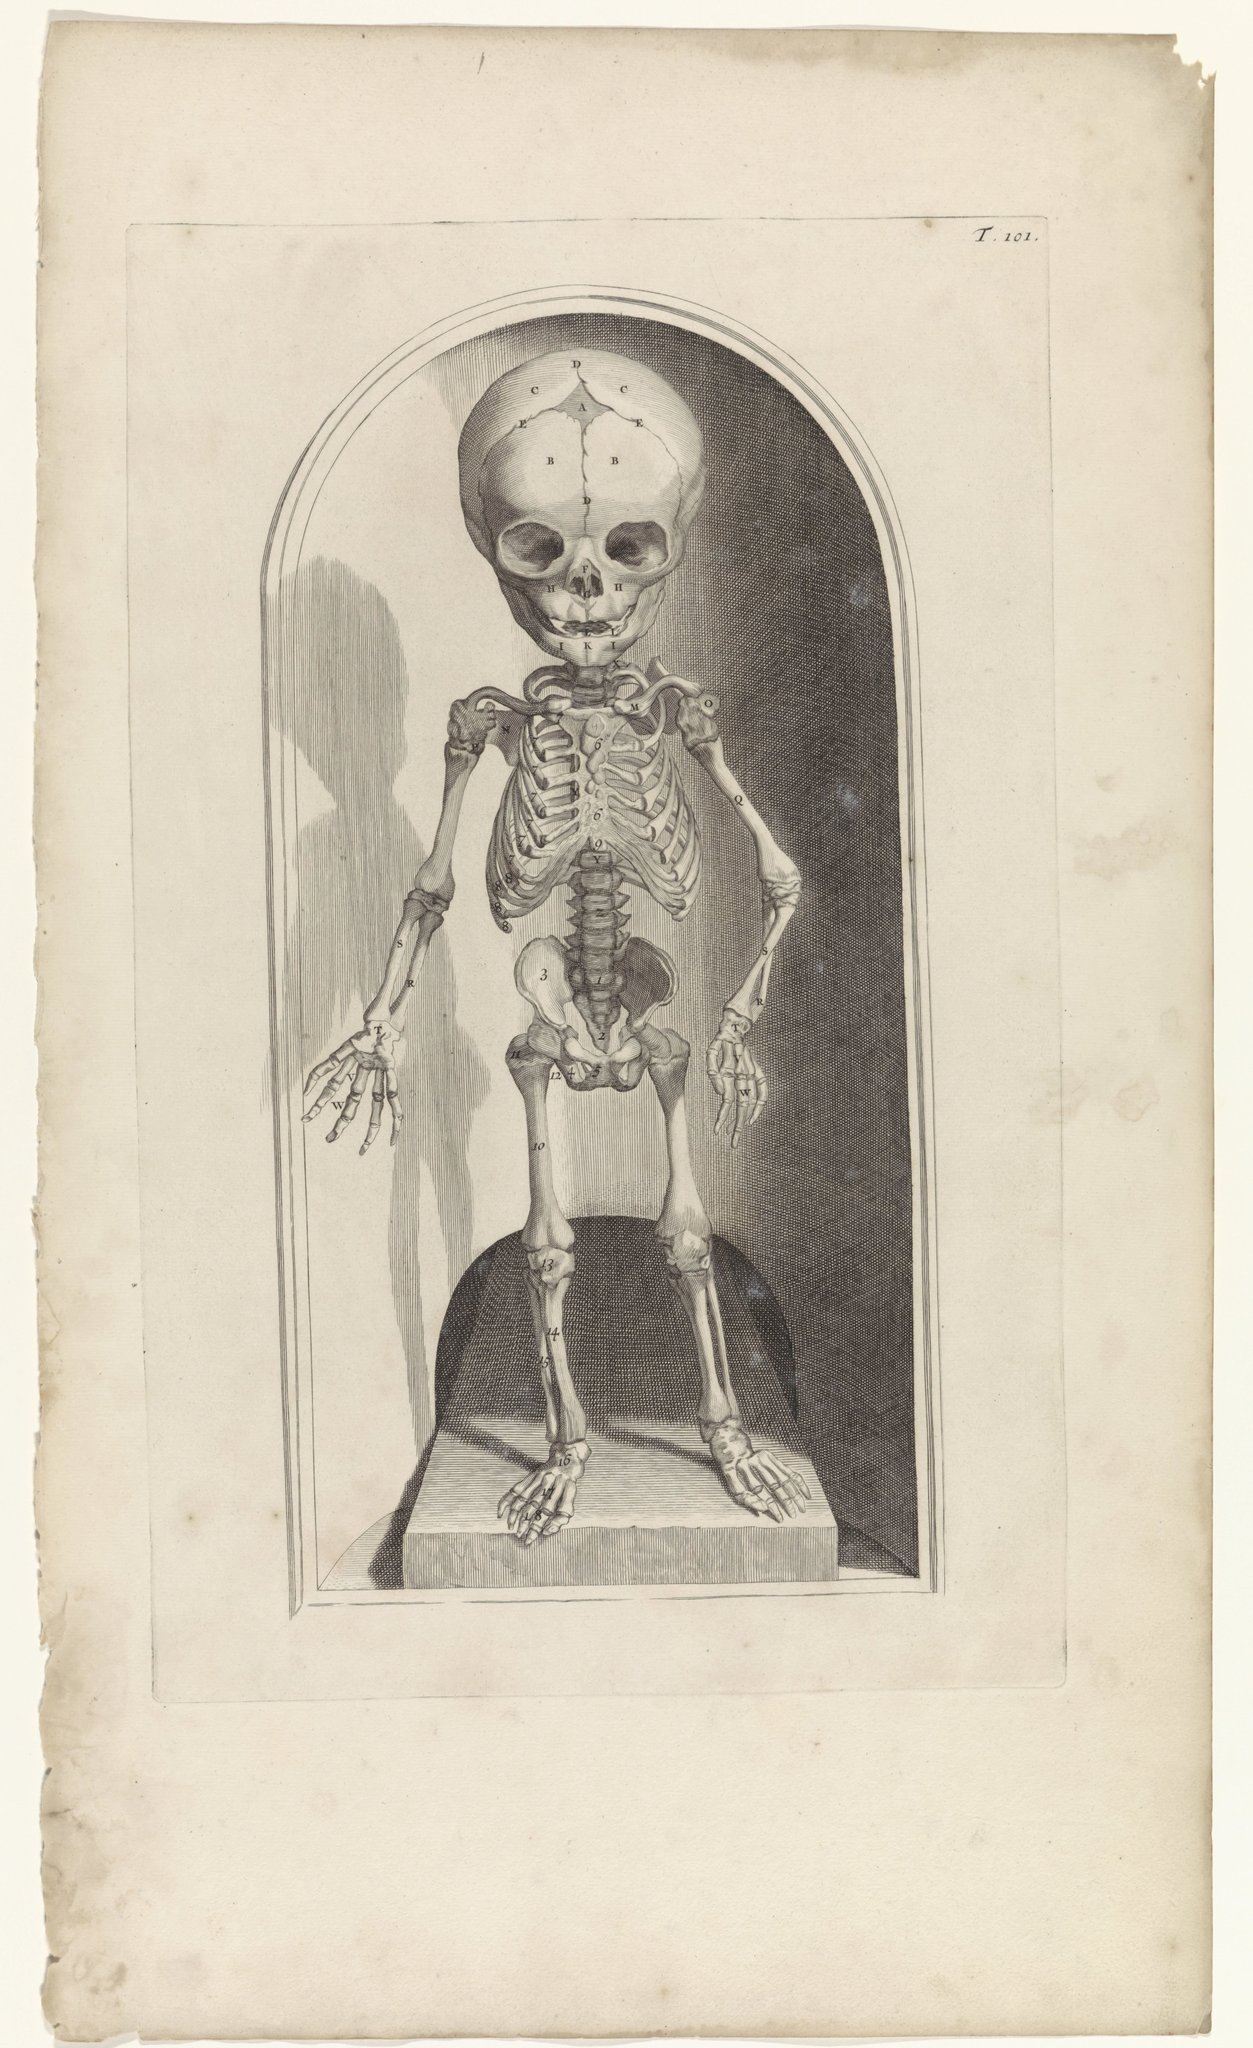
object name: print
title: Anatomische studie van het skelet van een foetus (voorkant)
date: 1685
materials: paper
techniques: engraving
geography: amsterdam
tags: (human) skeleton (+ front view), (human) skeleton (+ young male (human being)), foetus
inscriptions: collector's mark: Lugt 2228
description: Boekillustratie voor Bidloo, Godefridus. Anatomia humani corporis centum & quinque tabulis, per art. G. de Lairesse ad vivum delineatis, de monstrata, veterum recentiorumque inventis explicata plurimisque, hactenus non detectis, illustrata. Amsterdam: Weduwe Joannes van Someren, Hendrick Boom en erven Dirk Boom, 1685.